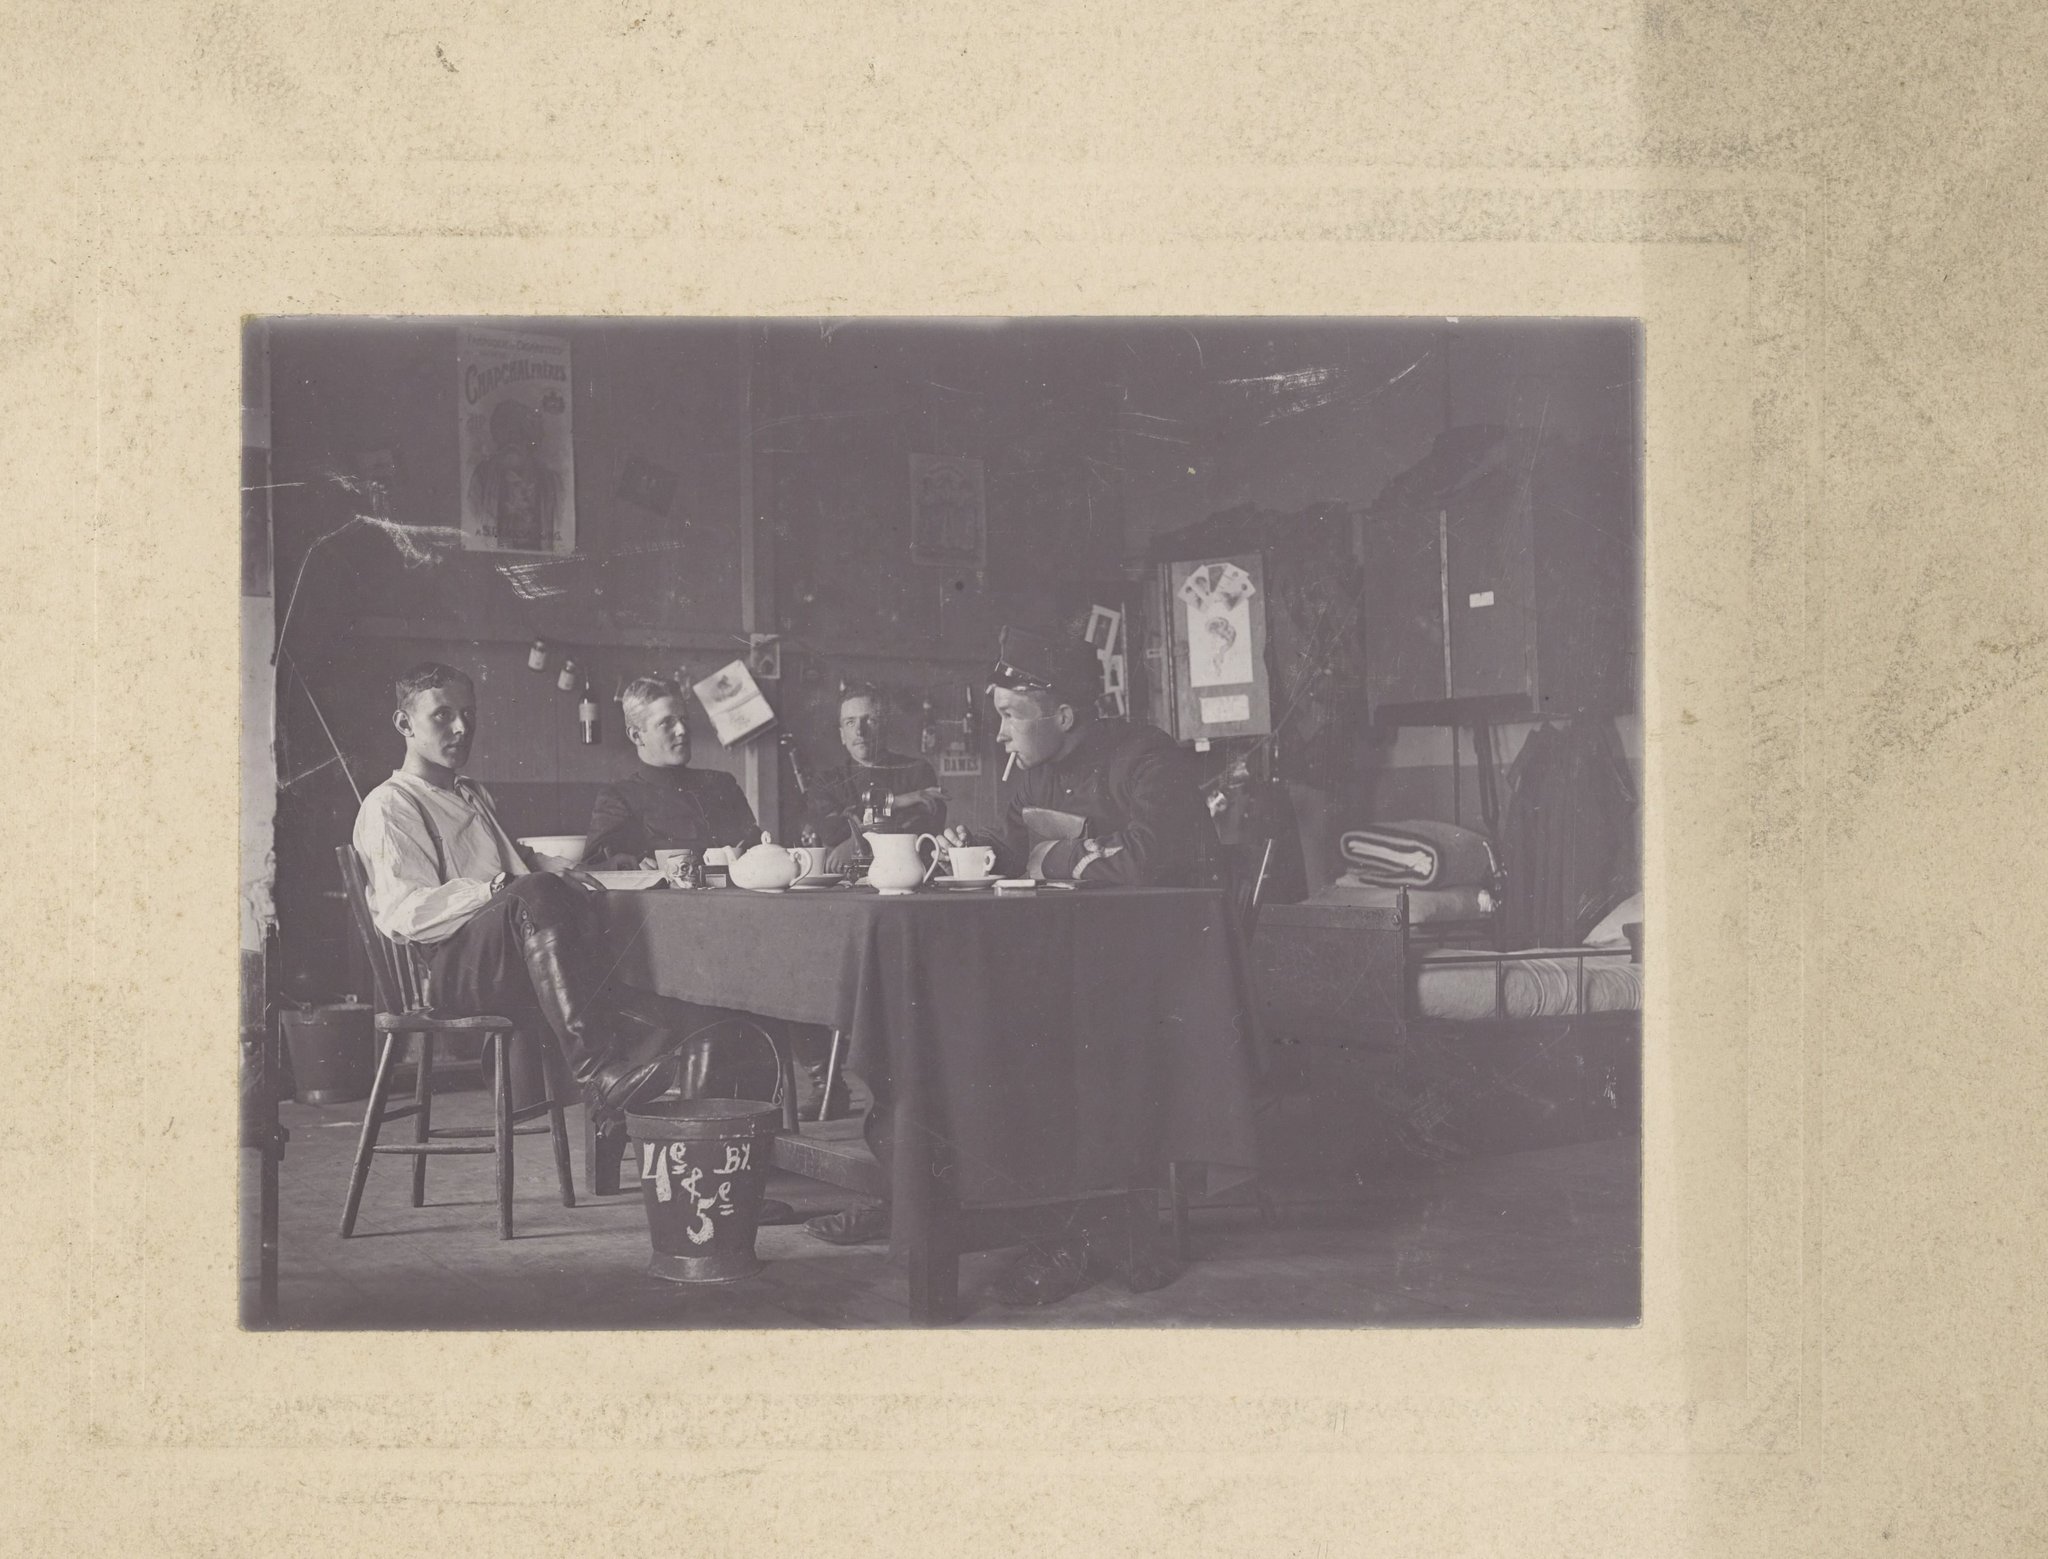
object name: photograph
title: Vier militairen aan tafel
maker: Anonymous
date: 1910-1915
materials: cardboard, photographic support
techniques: collodion silver print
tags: breda